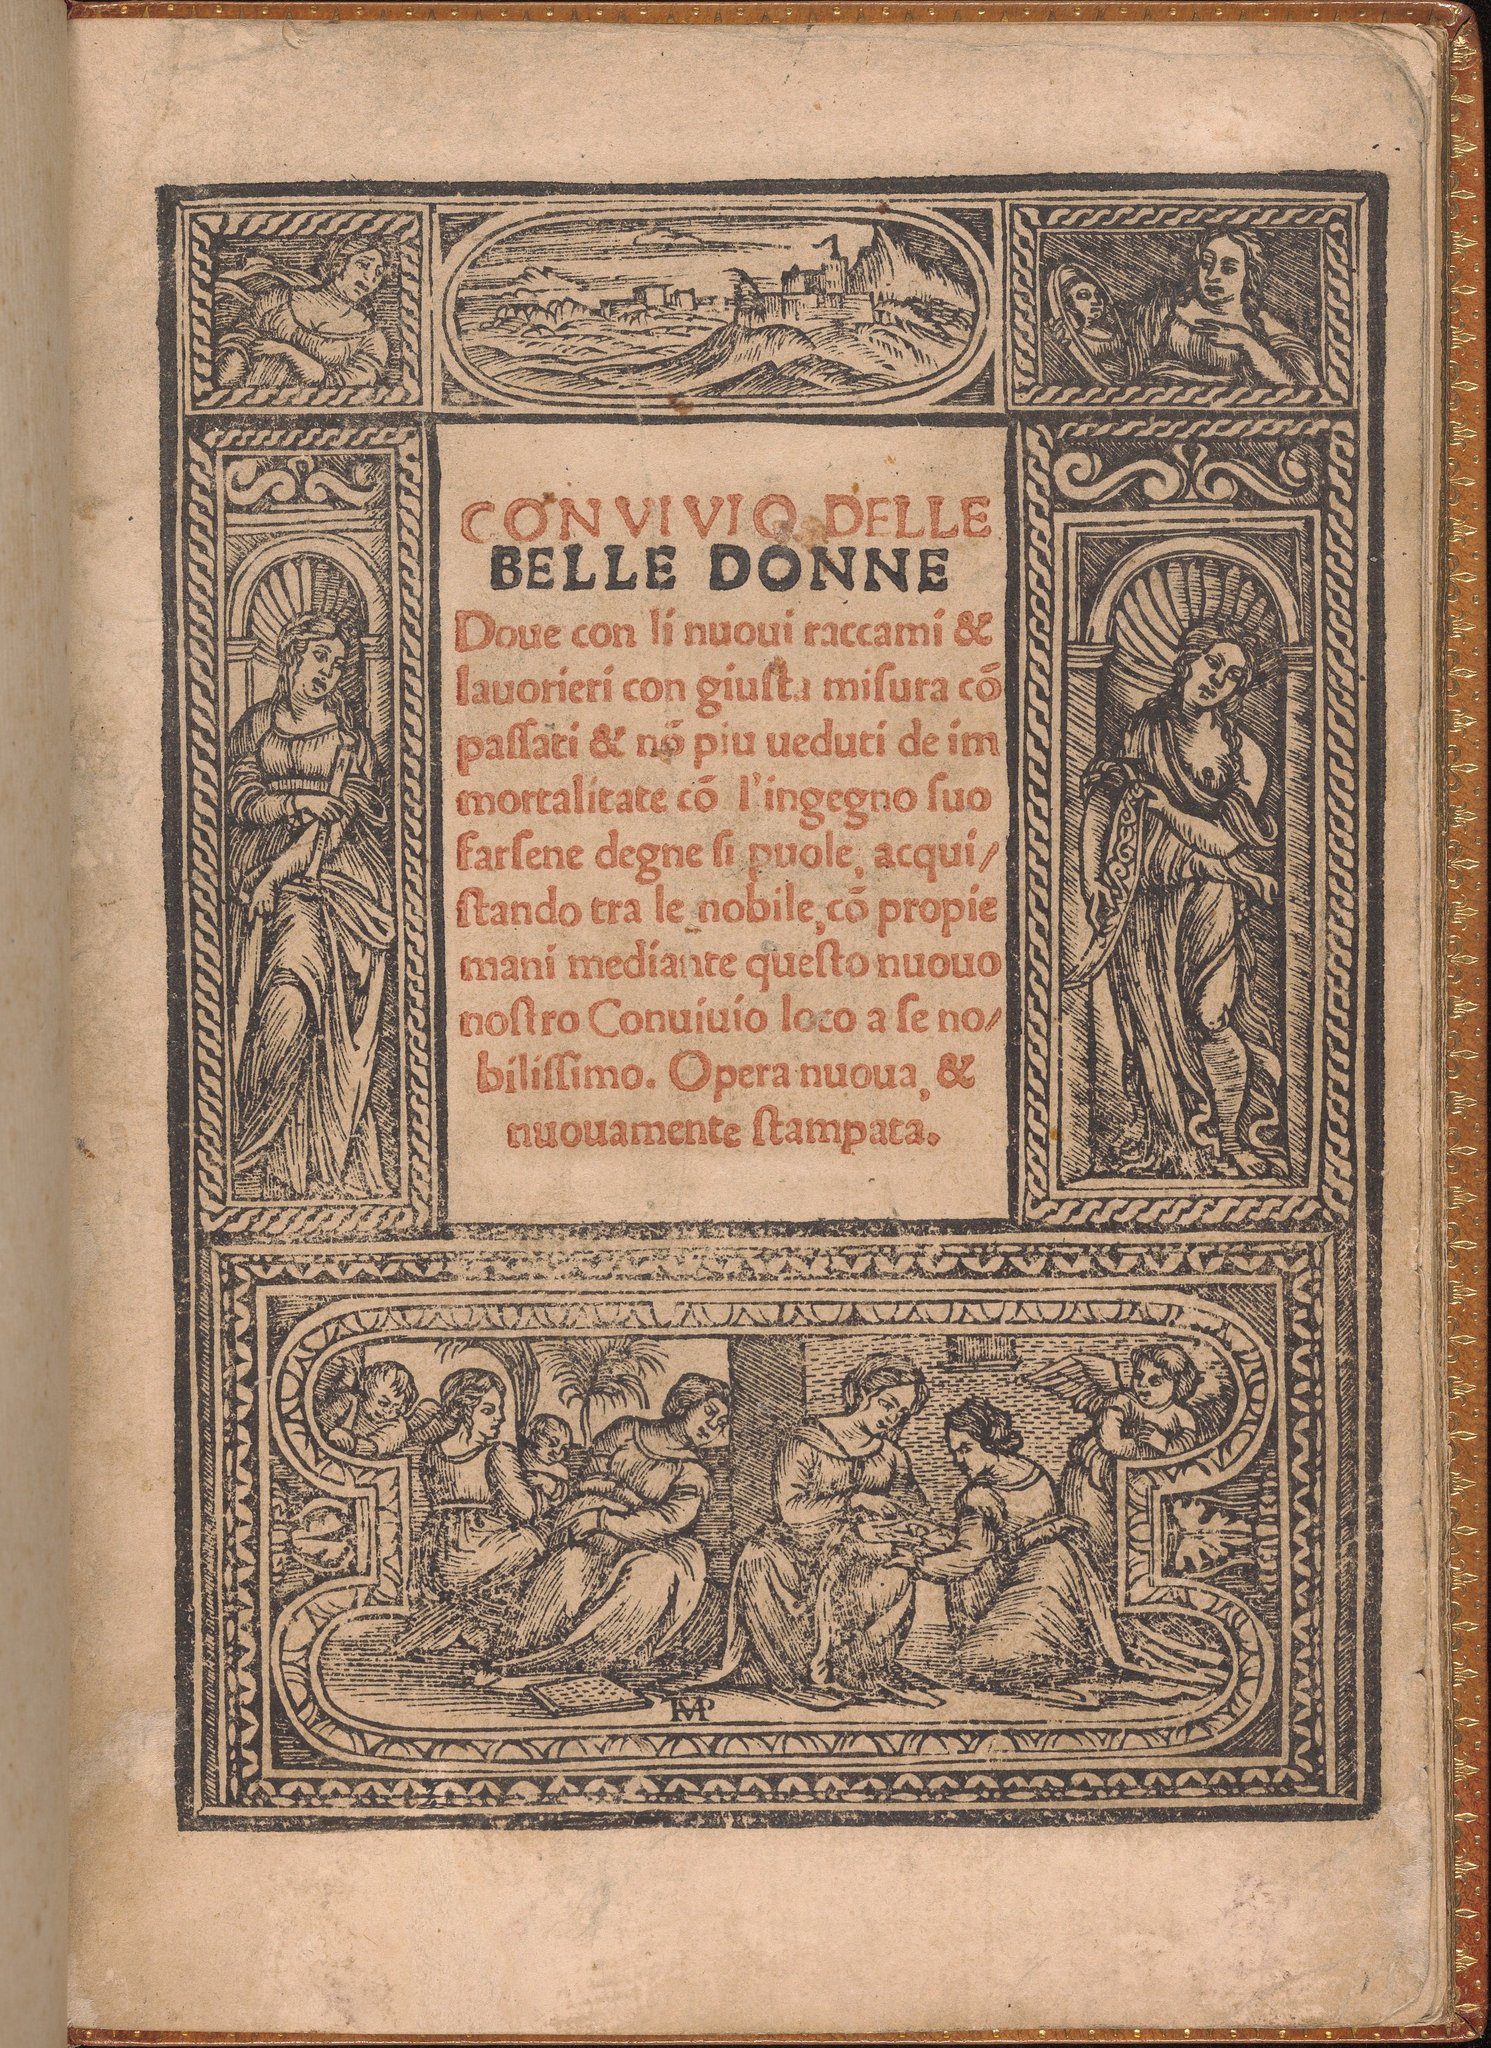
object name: book print ornament architecture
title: Convivio delle Belle Donne, title page (recto)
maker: nicolò zoppino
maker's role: publisher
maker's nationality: italian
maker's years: 1478-1544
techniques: woodcut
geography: italy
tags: women